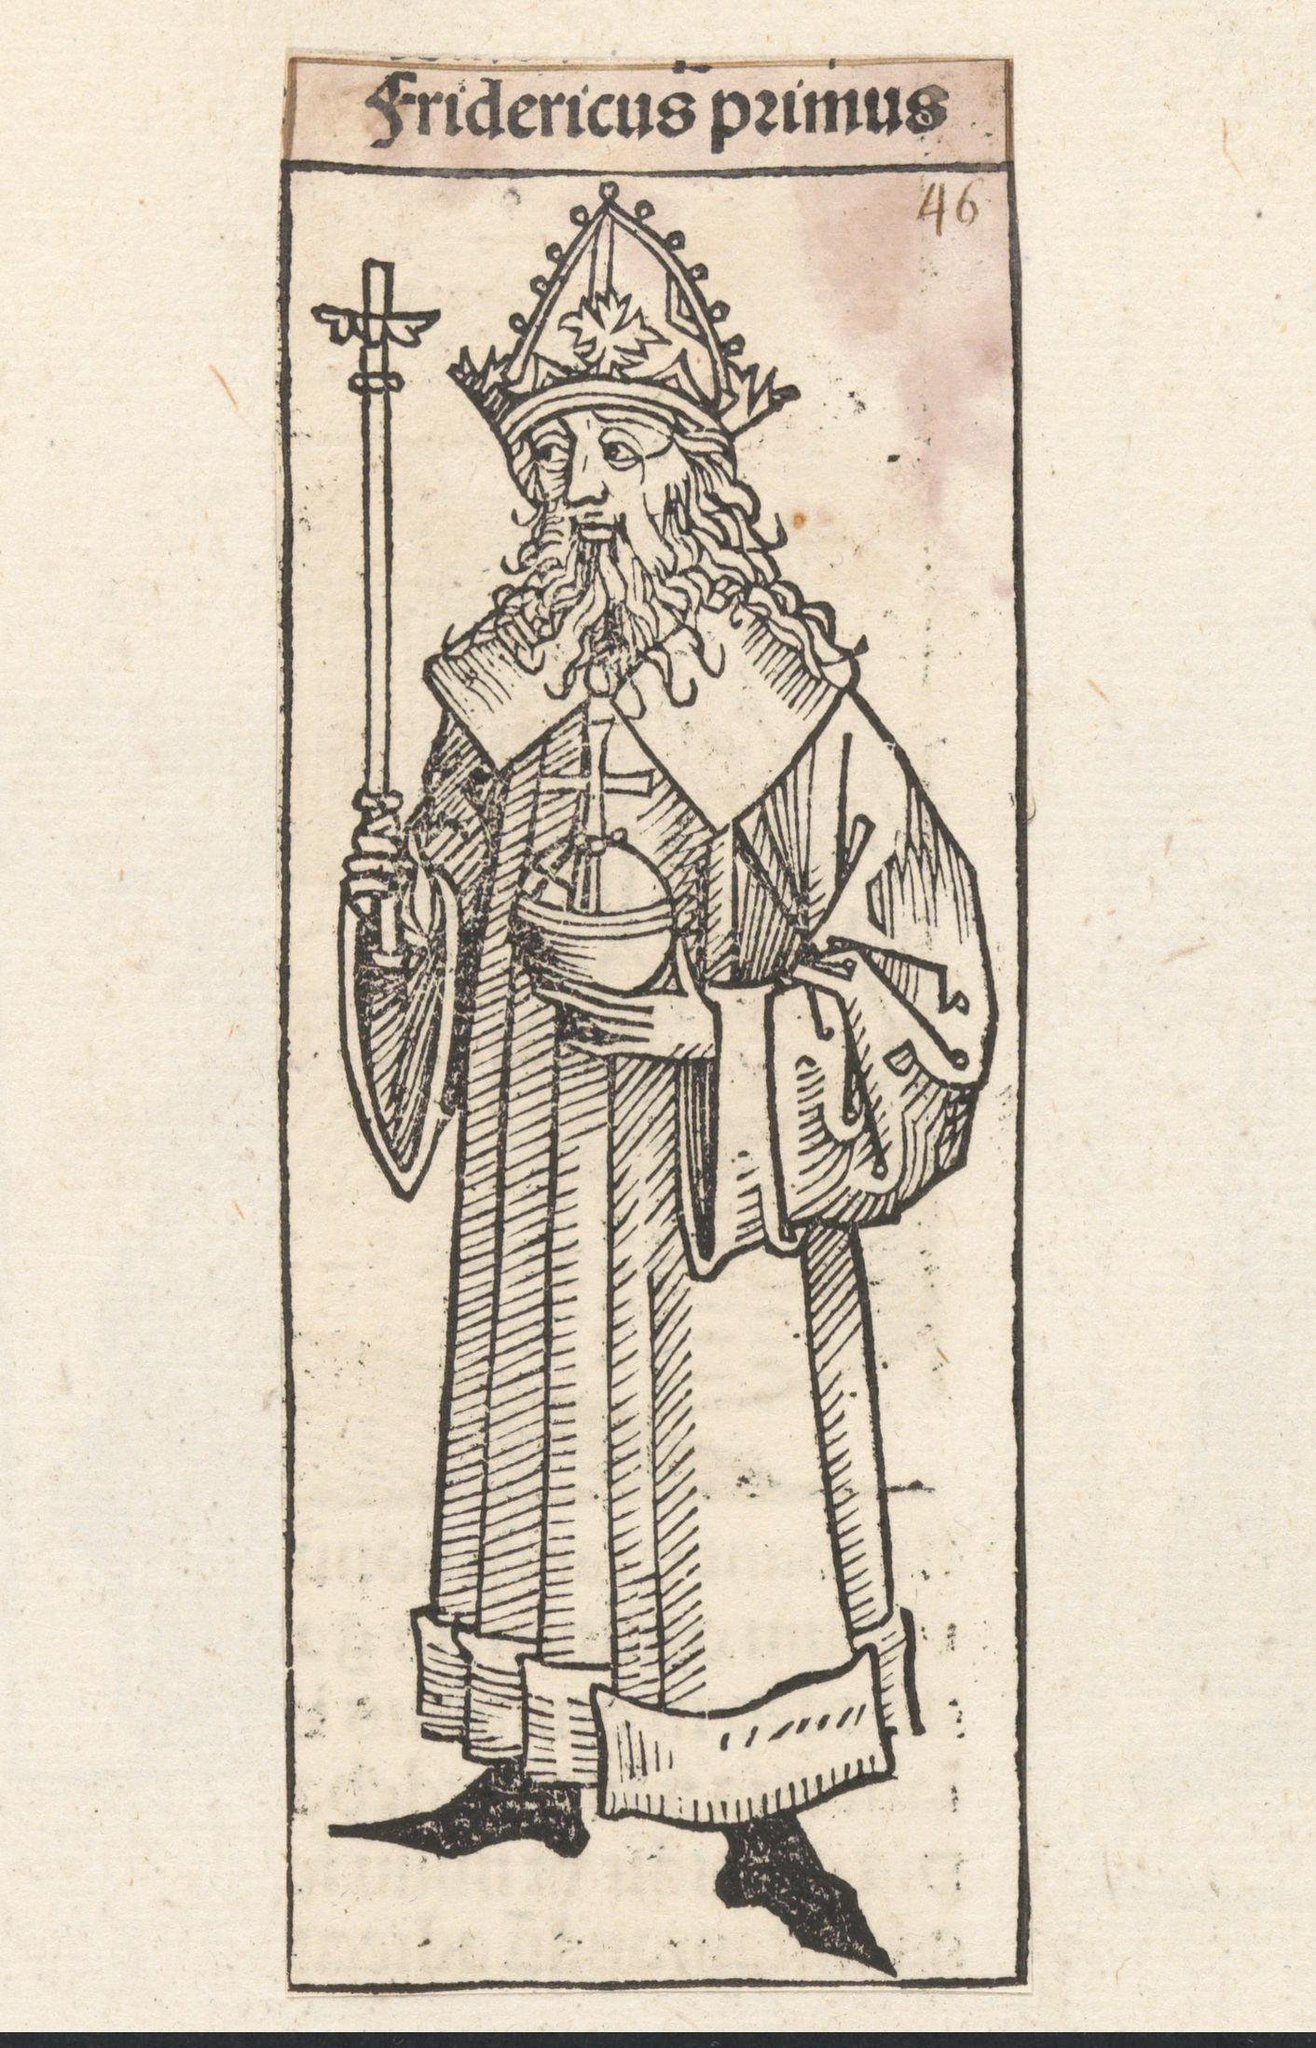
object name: album leaf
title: Liber Chronicarum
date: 1493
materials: paper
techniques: letterpress printing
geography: nuremberg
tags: emperor, king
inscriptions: inscription: ‘46’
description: Een koning met rijksappel en scepter, ten voeten uit. De voorstelling is onderdeel van de opeenvolging keizers in de Liber Chronicarum. De tekst identificeert de man als keizer Frederik I Barbarossa. De prent maakt deel uit van een album.